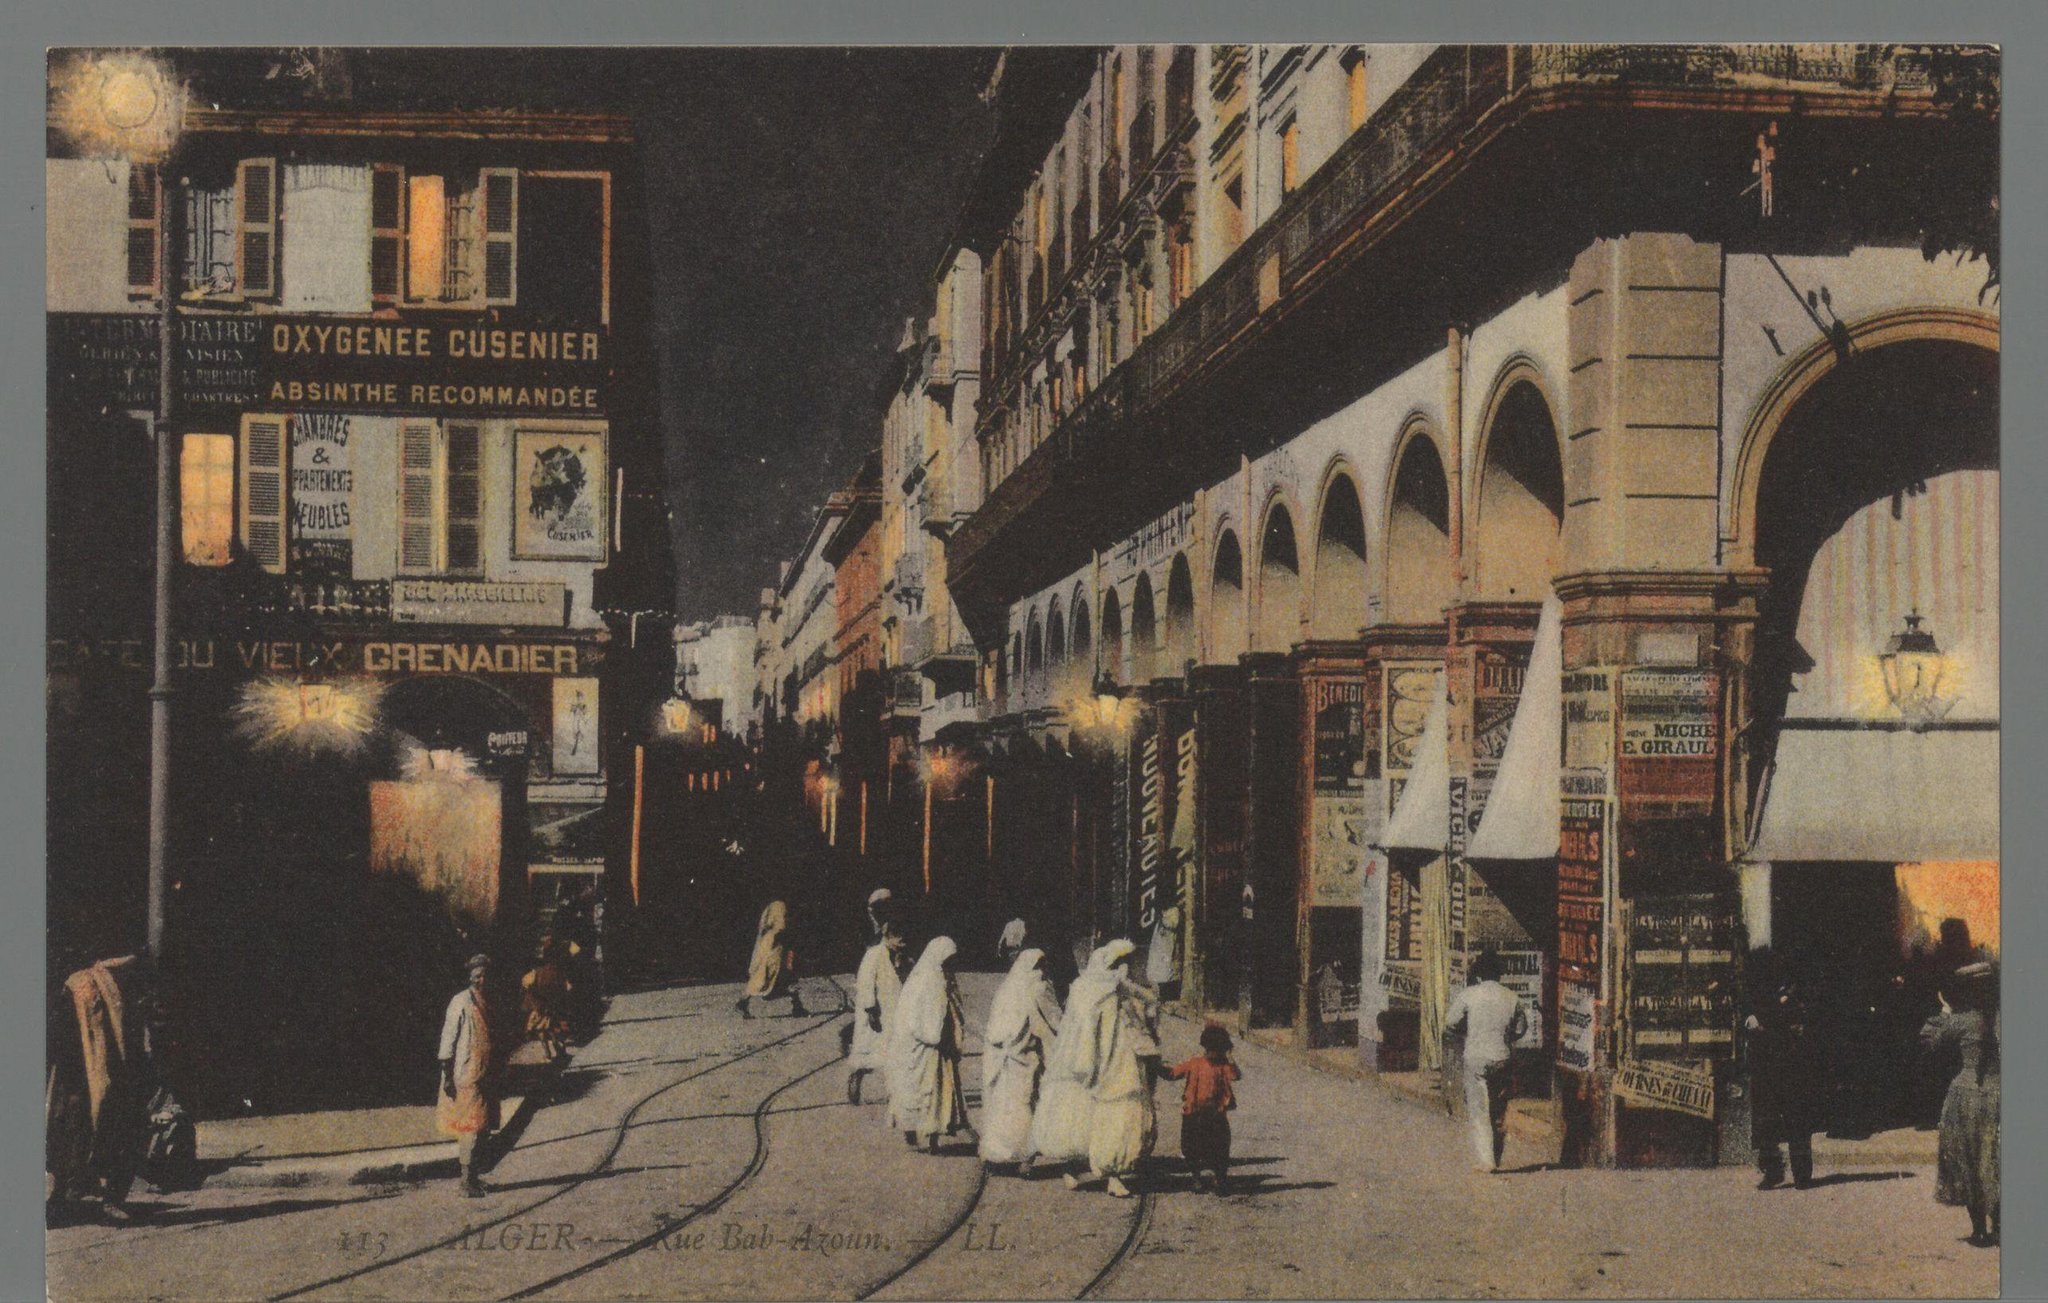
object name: ansichtkaart, prentbriefkaart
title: Alger. Rue Bab-Azoun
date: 1903-1905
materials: cardboard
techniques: photograph, lithograph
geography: algiers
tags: night, street (+ city(-scape) with figures, staffage)